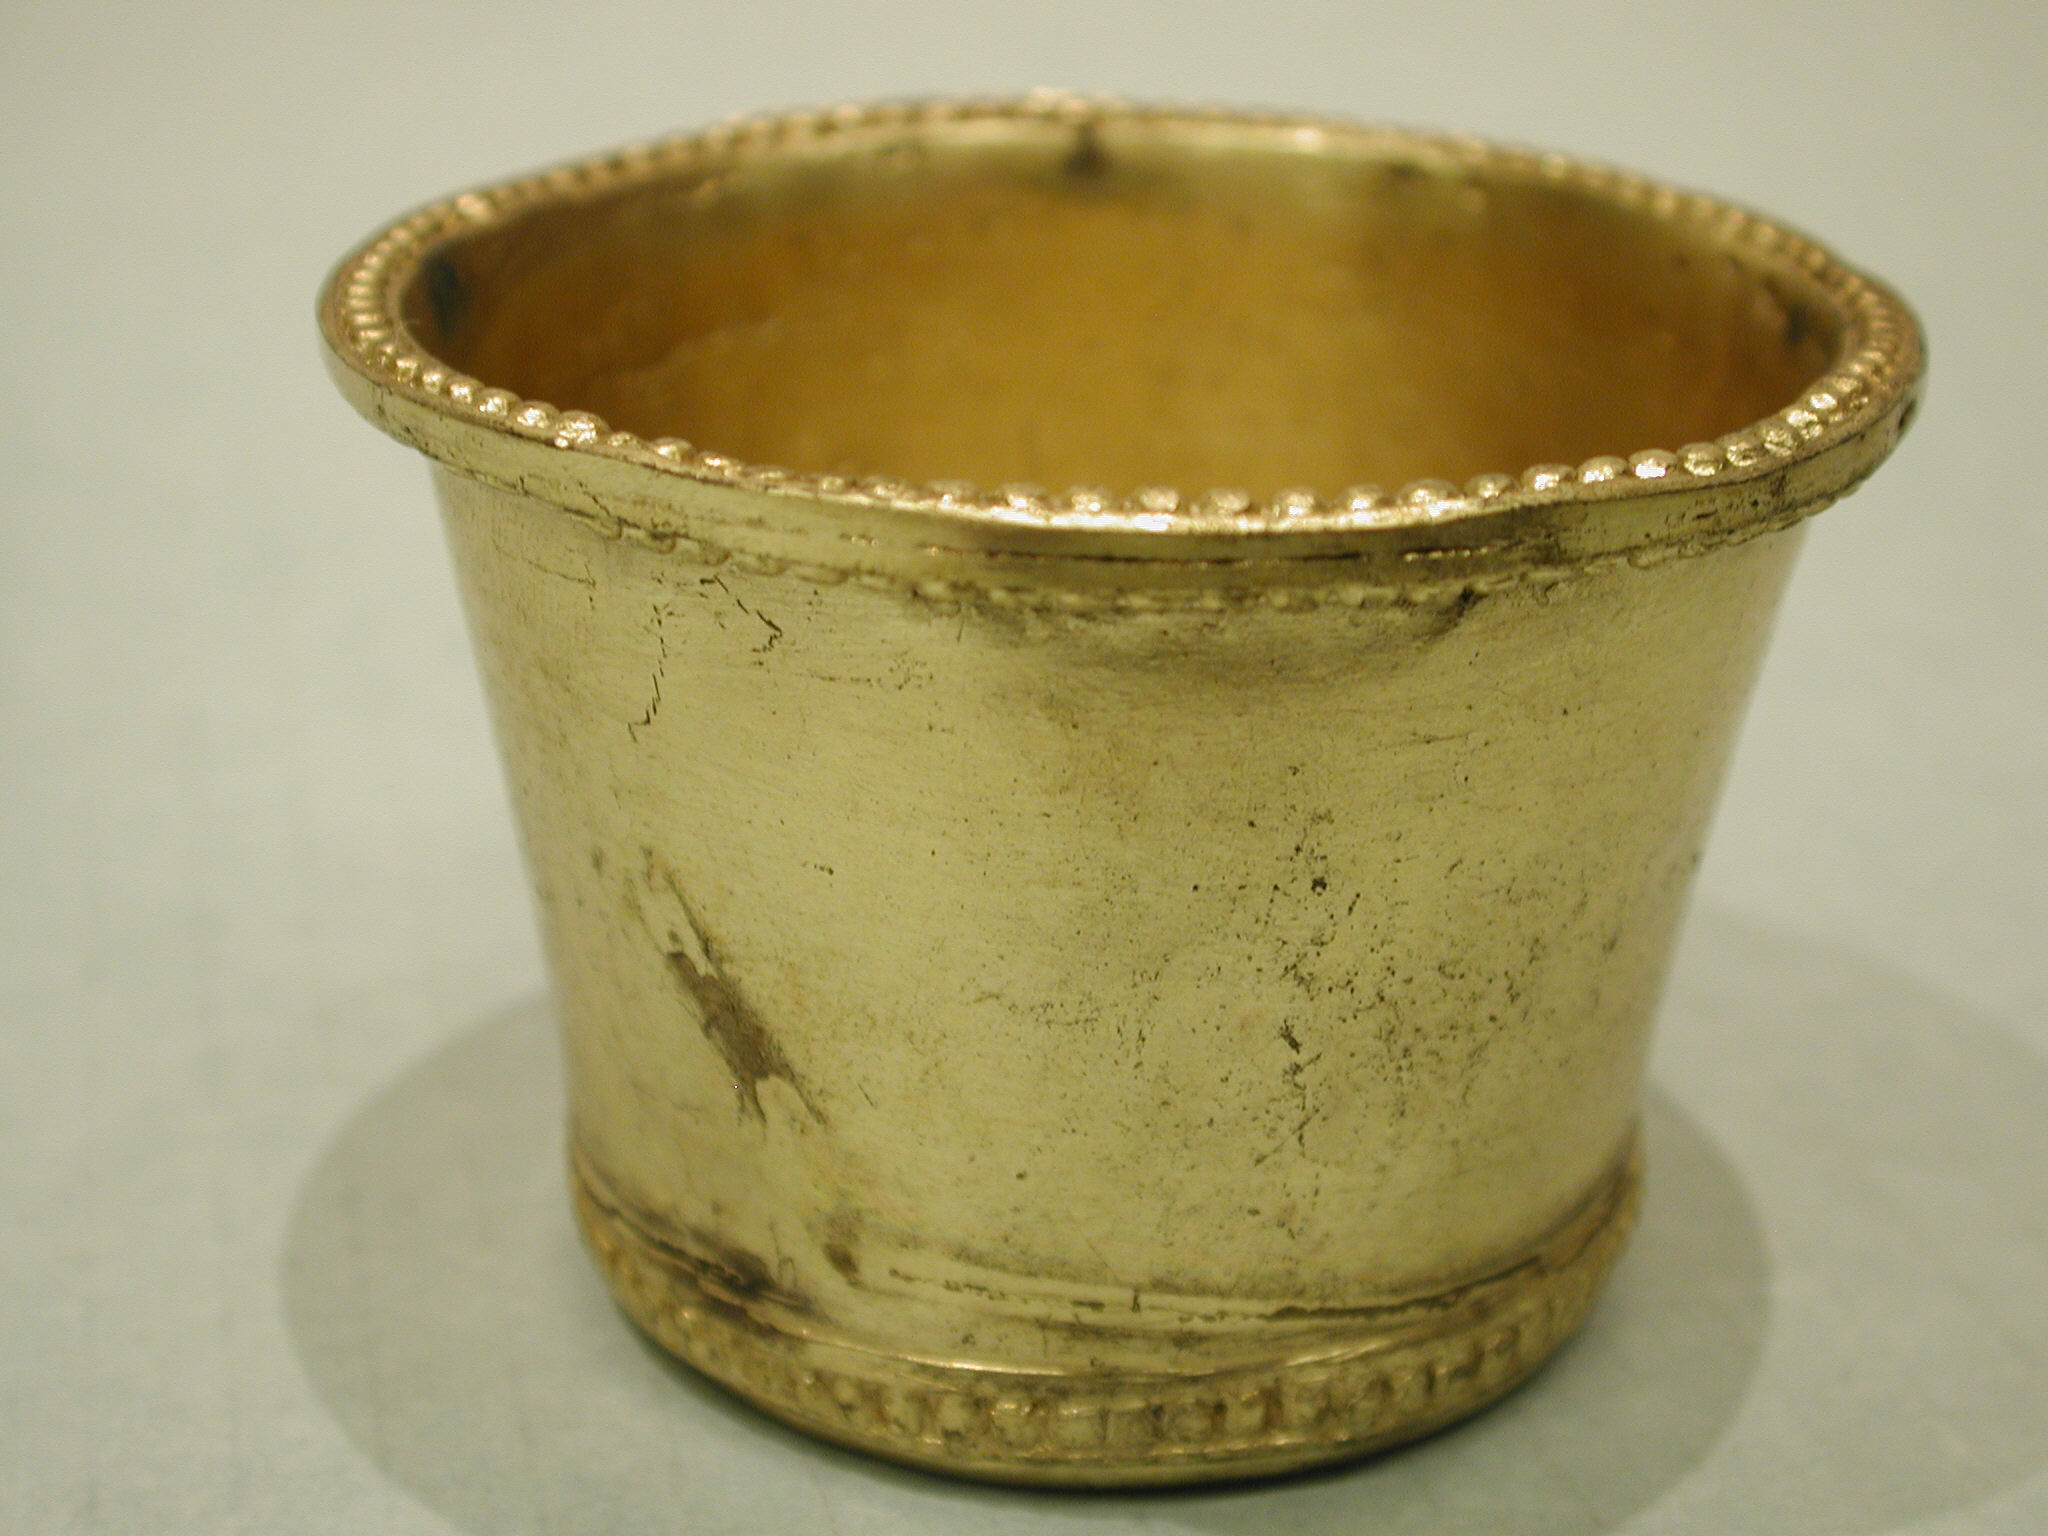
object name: beaker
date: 1801-1900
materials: metal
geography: hungary